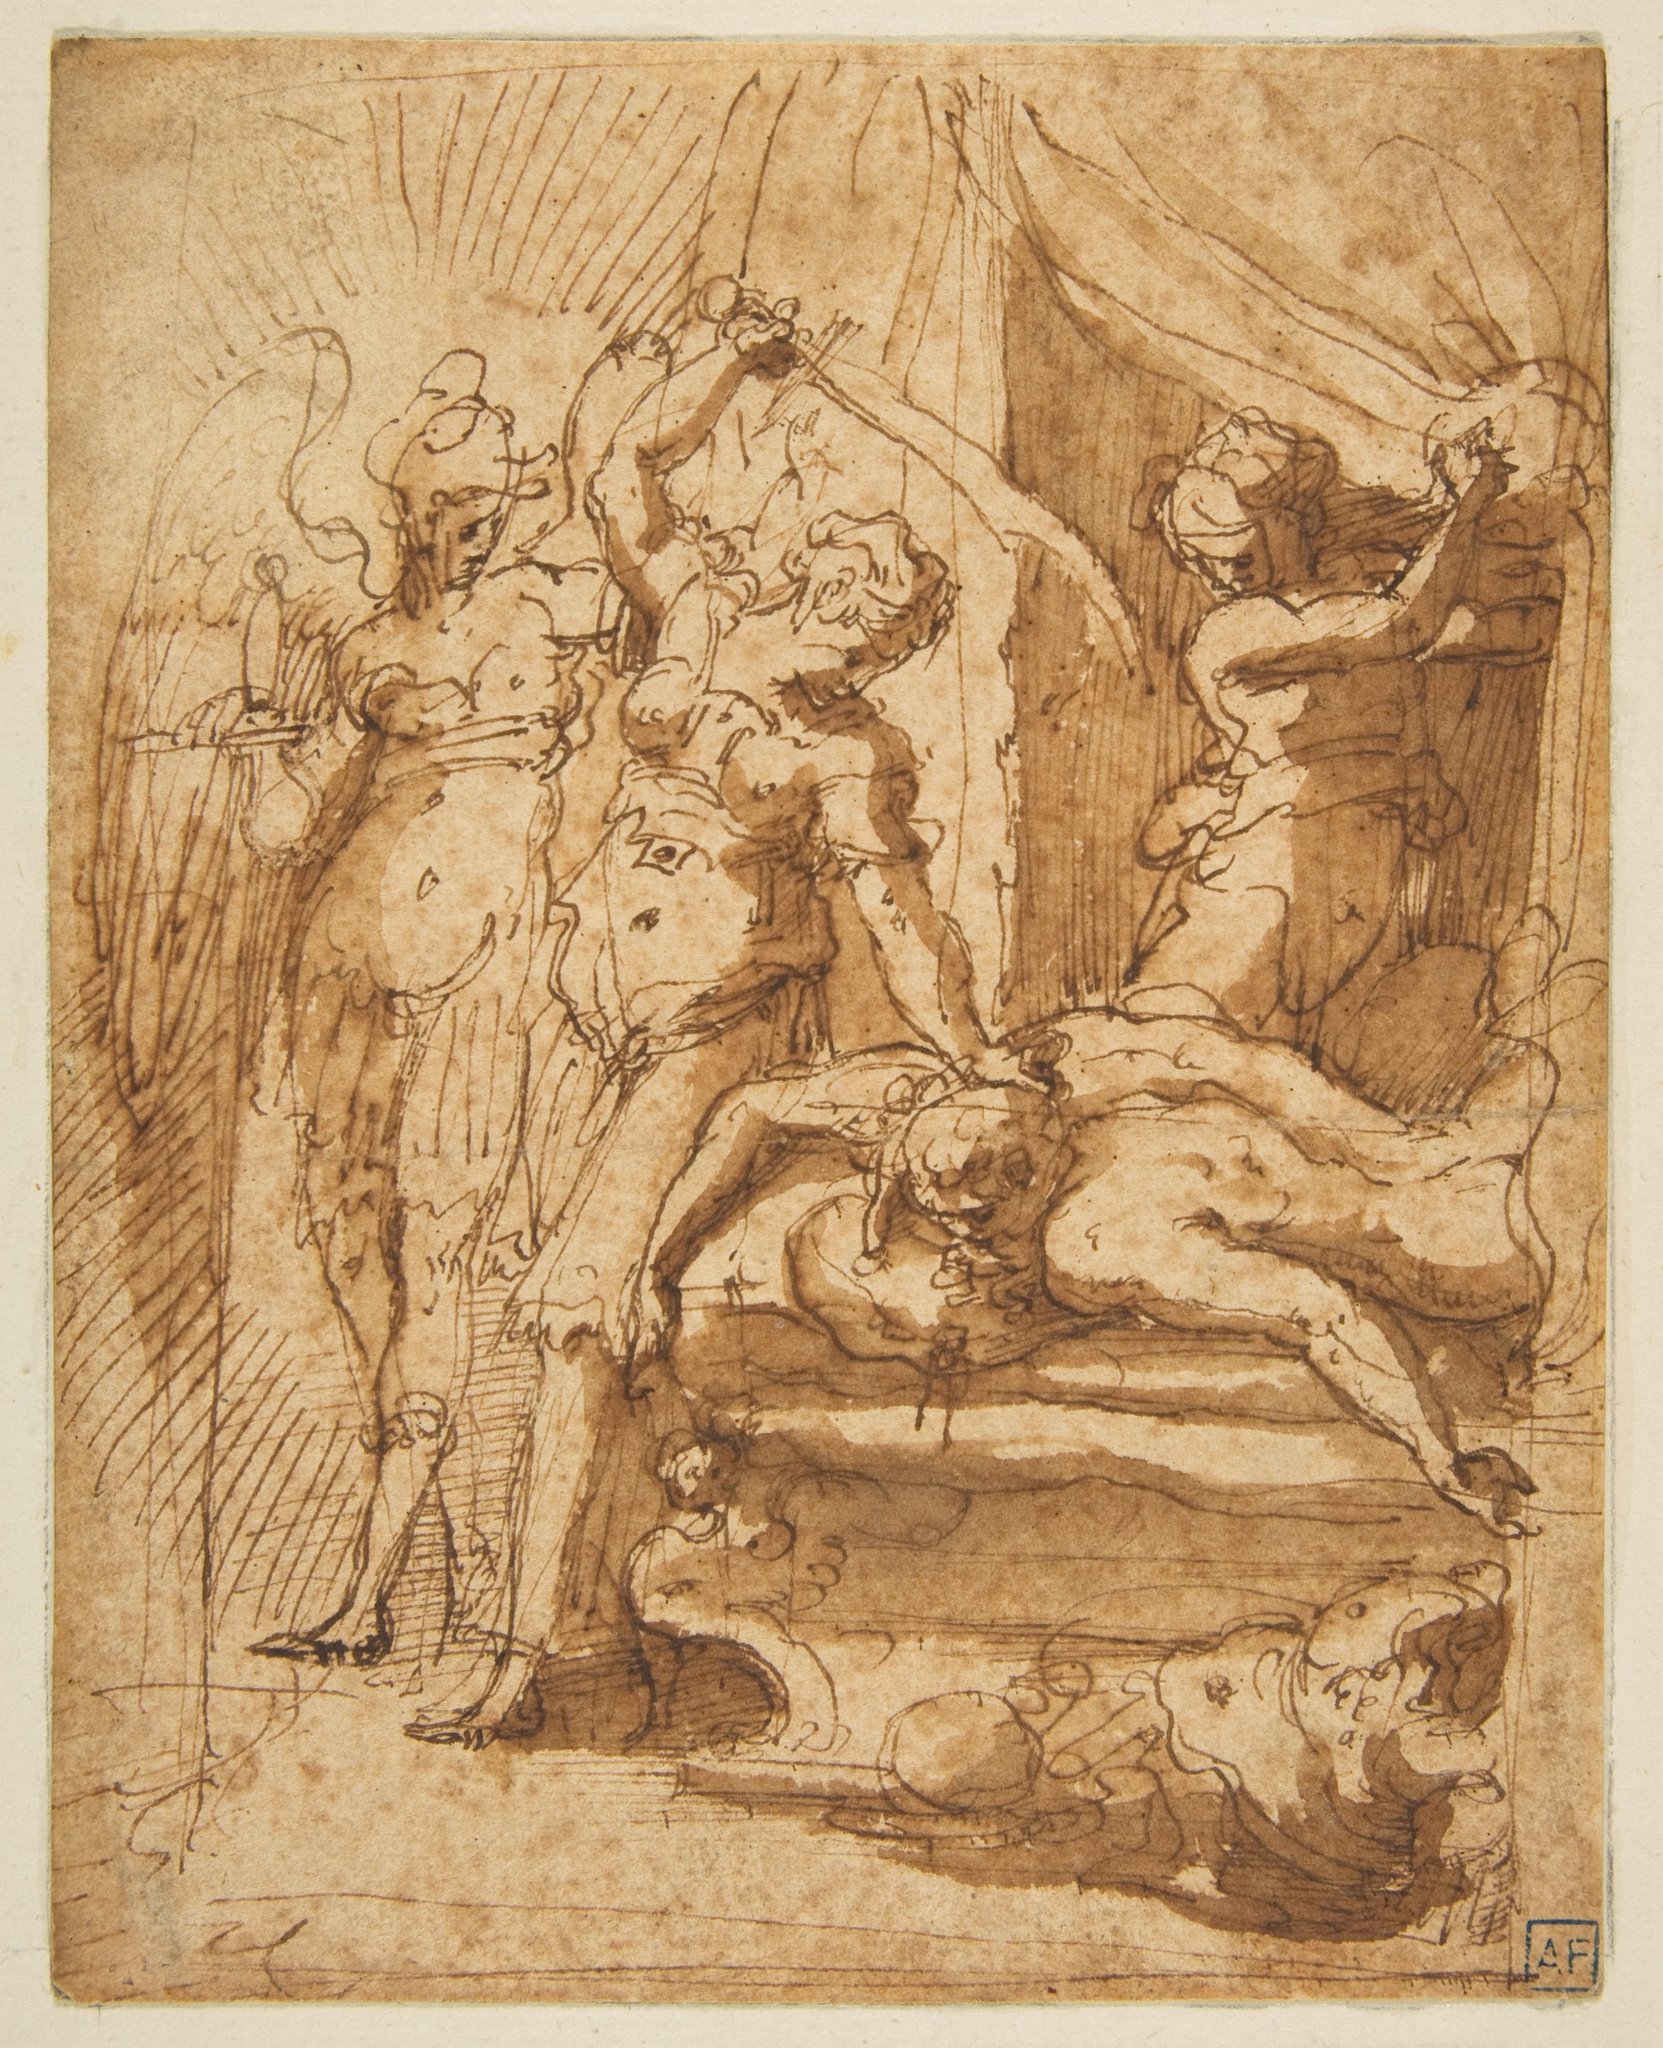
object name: drawing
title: Judith Decapitating Holofernes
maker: giorgio vasari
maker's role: artist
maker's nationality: italian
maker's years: 1511-1574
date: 1511-1574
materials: ink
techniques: pen, wash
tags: weapons,holofernes,judith